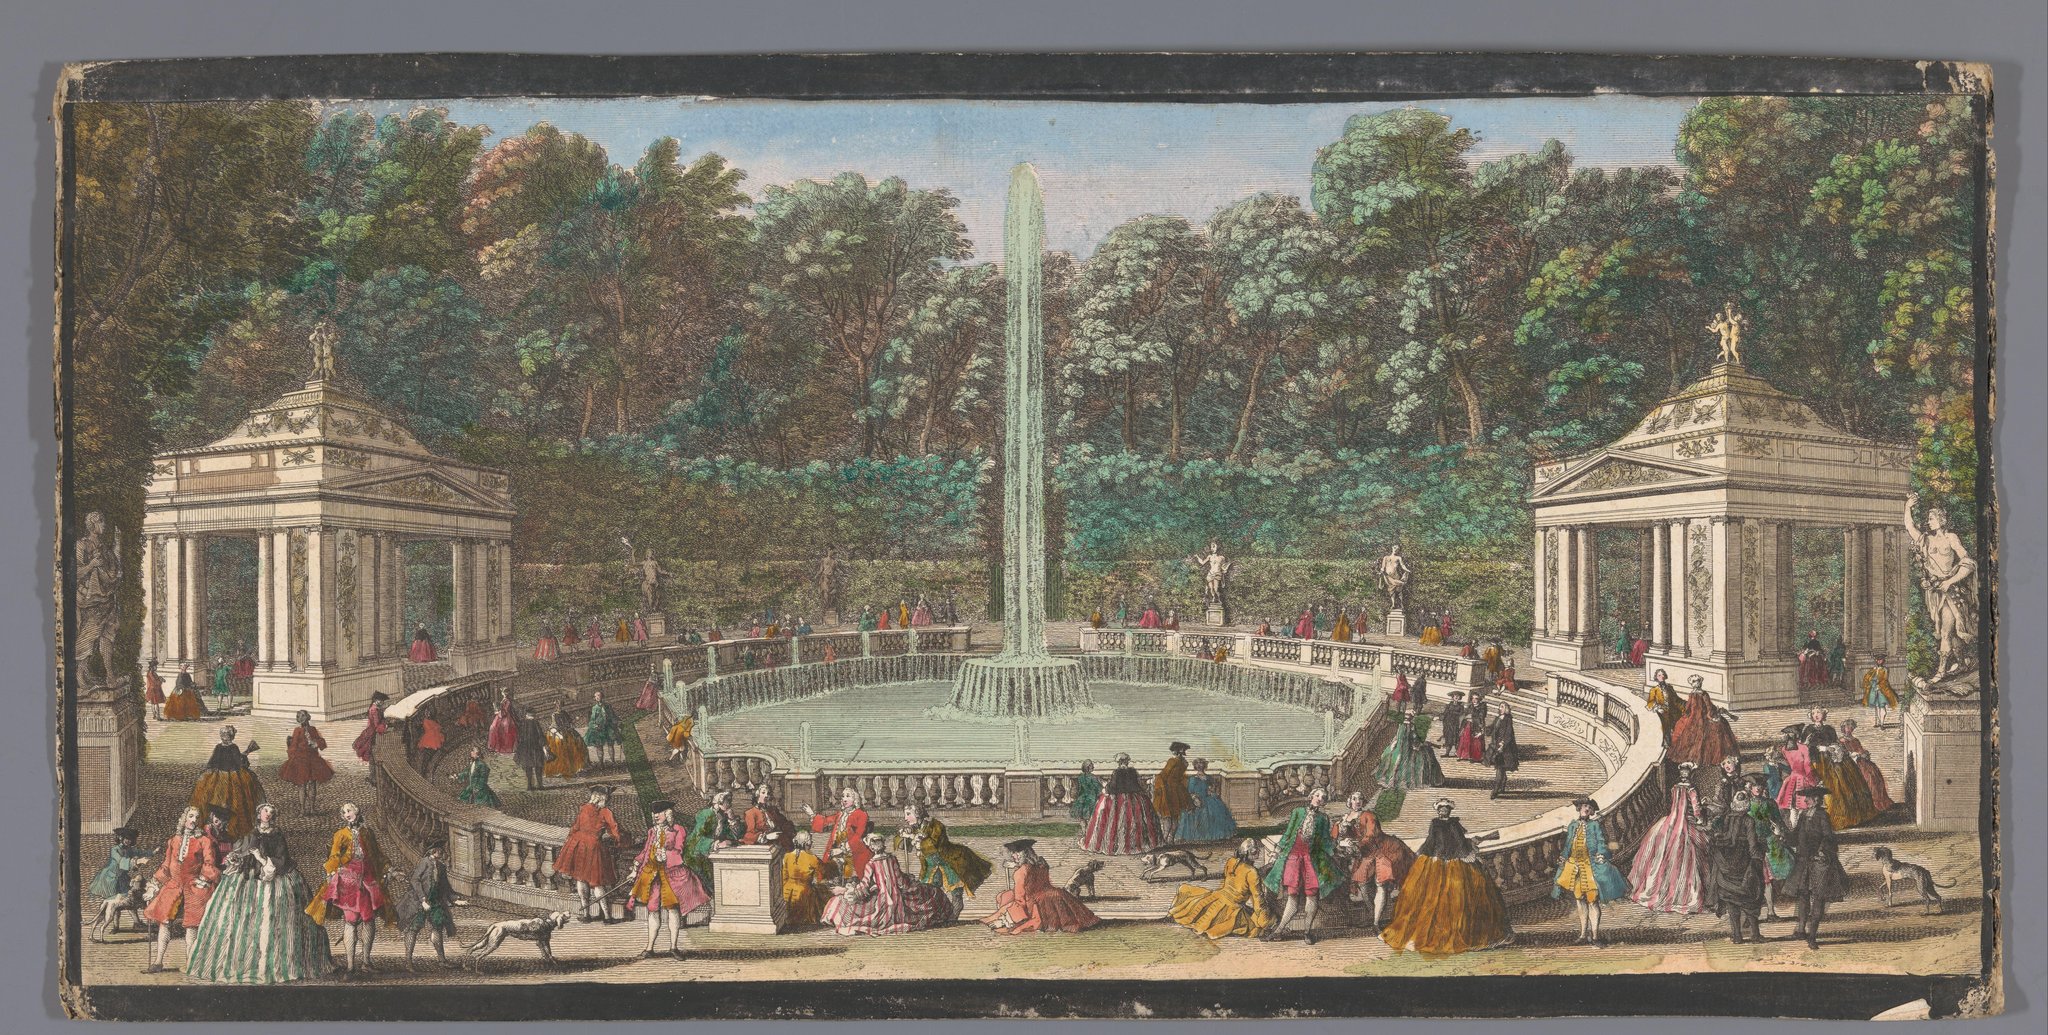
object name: opticaprent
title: Les Domes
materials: cardboard, paper, watercolor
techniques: brush, etching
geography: paris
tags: garden, garden fountain, ornamental plants, garden ornaments, garden buildings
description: In de ondermarge vier regels Franse tekst.